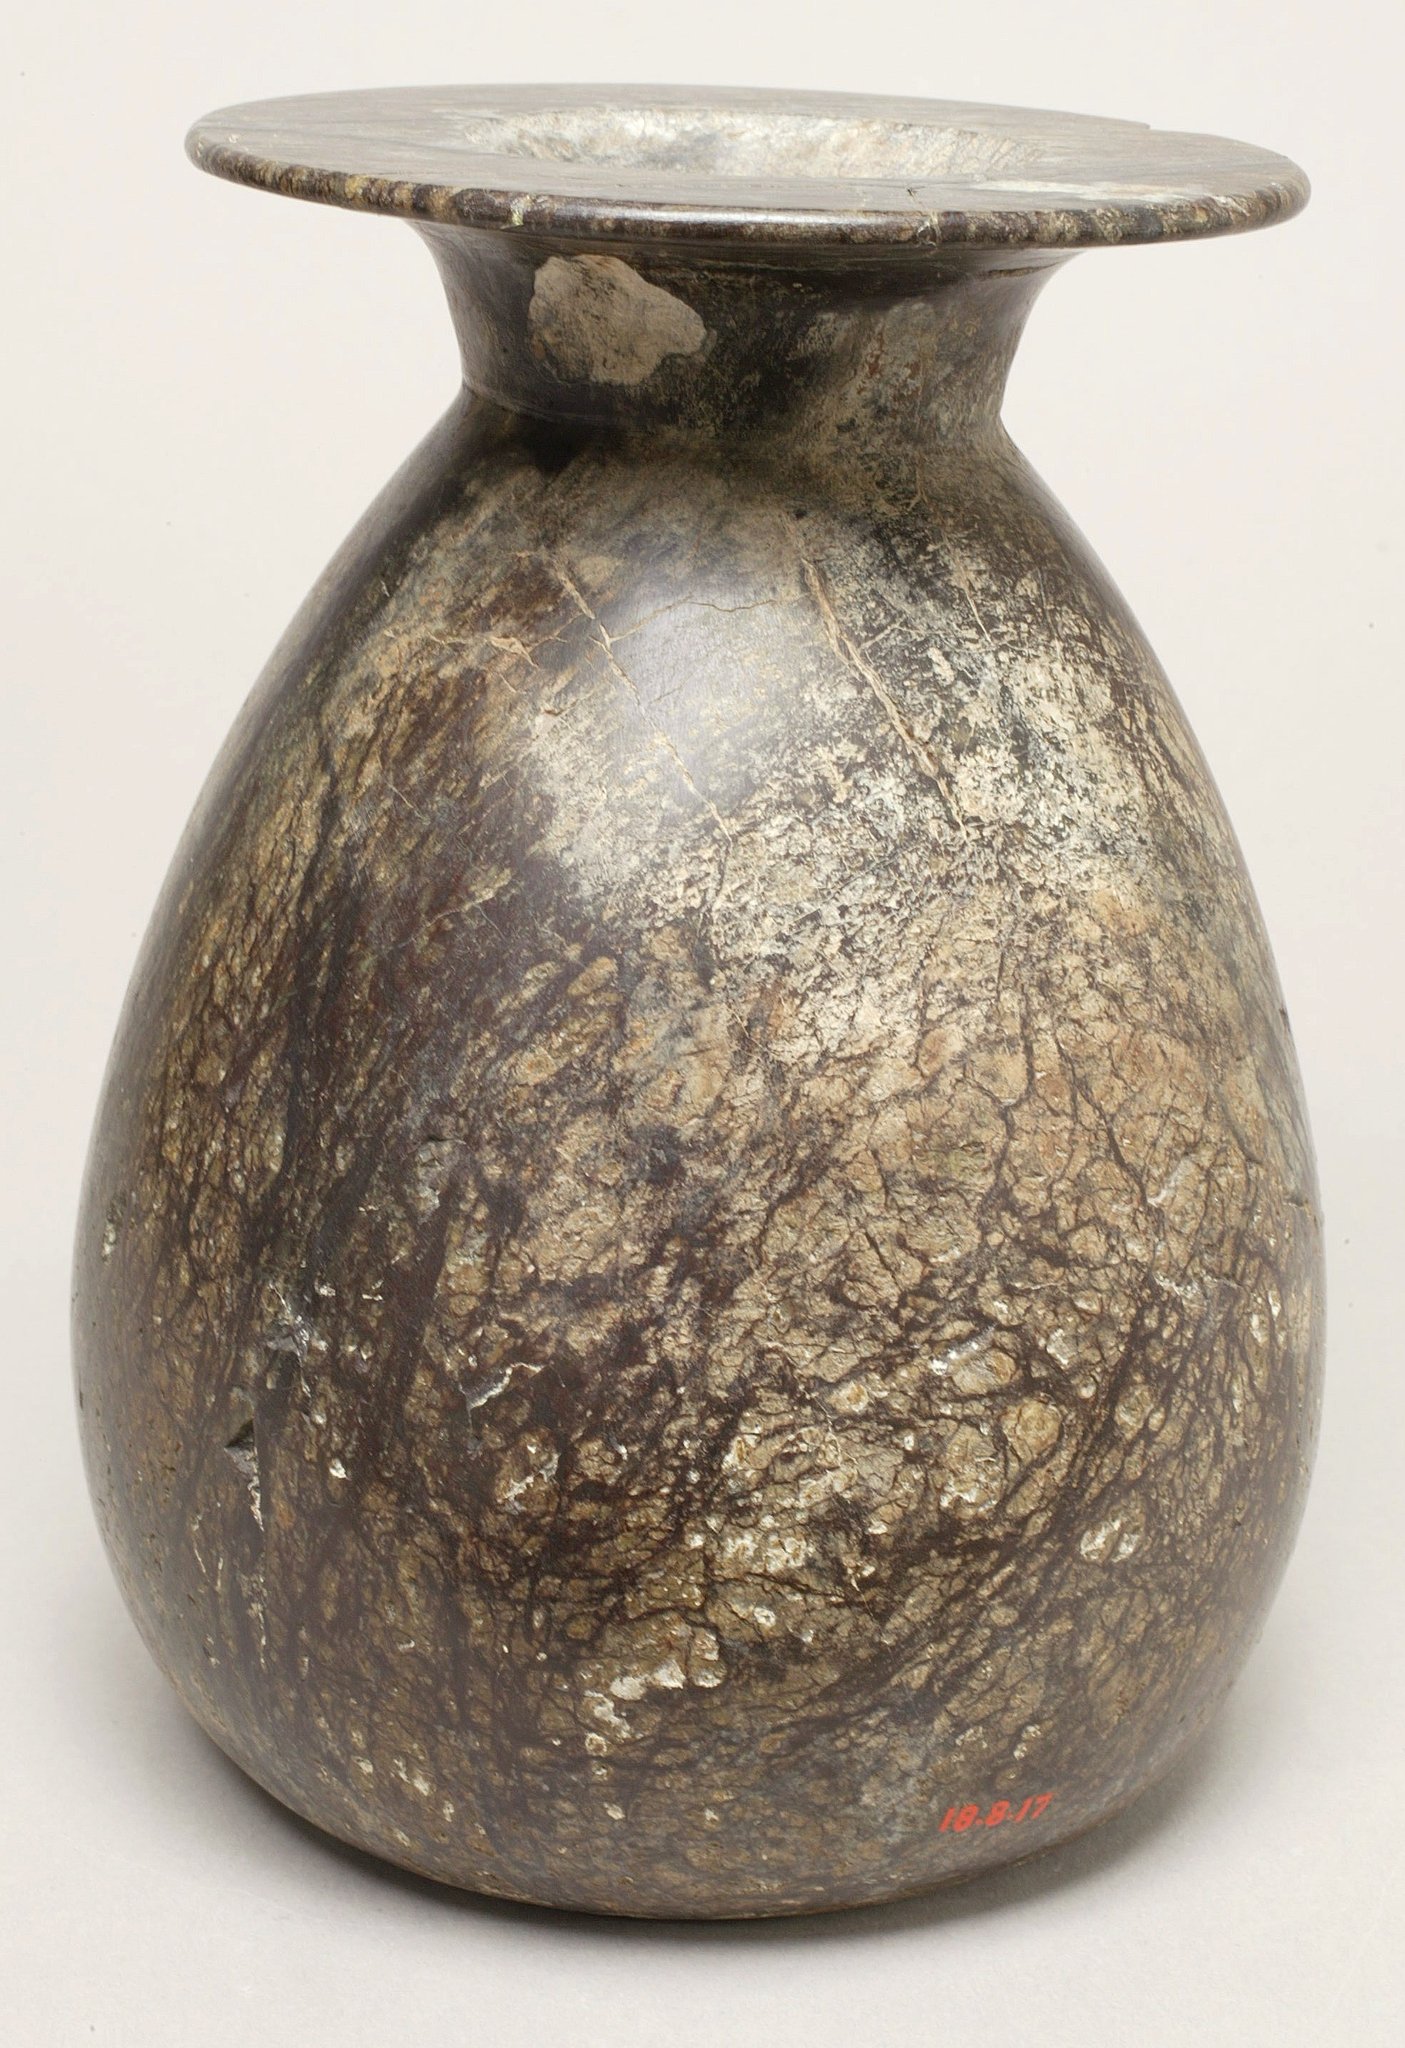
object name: jar, piriform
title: Piriform Stone Jar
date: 1479-1425 BCE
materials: stone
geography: egypt